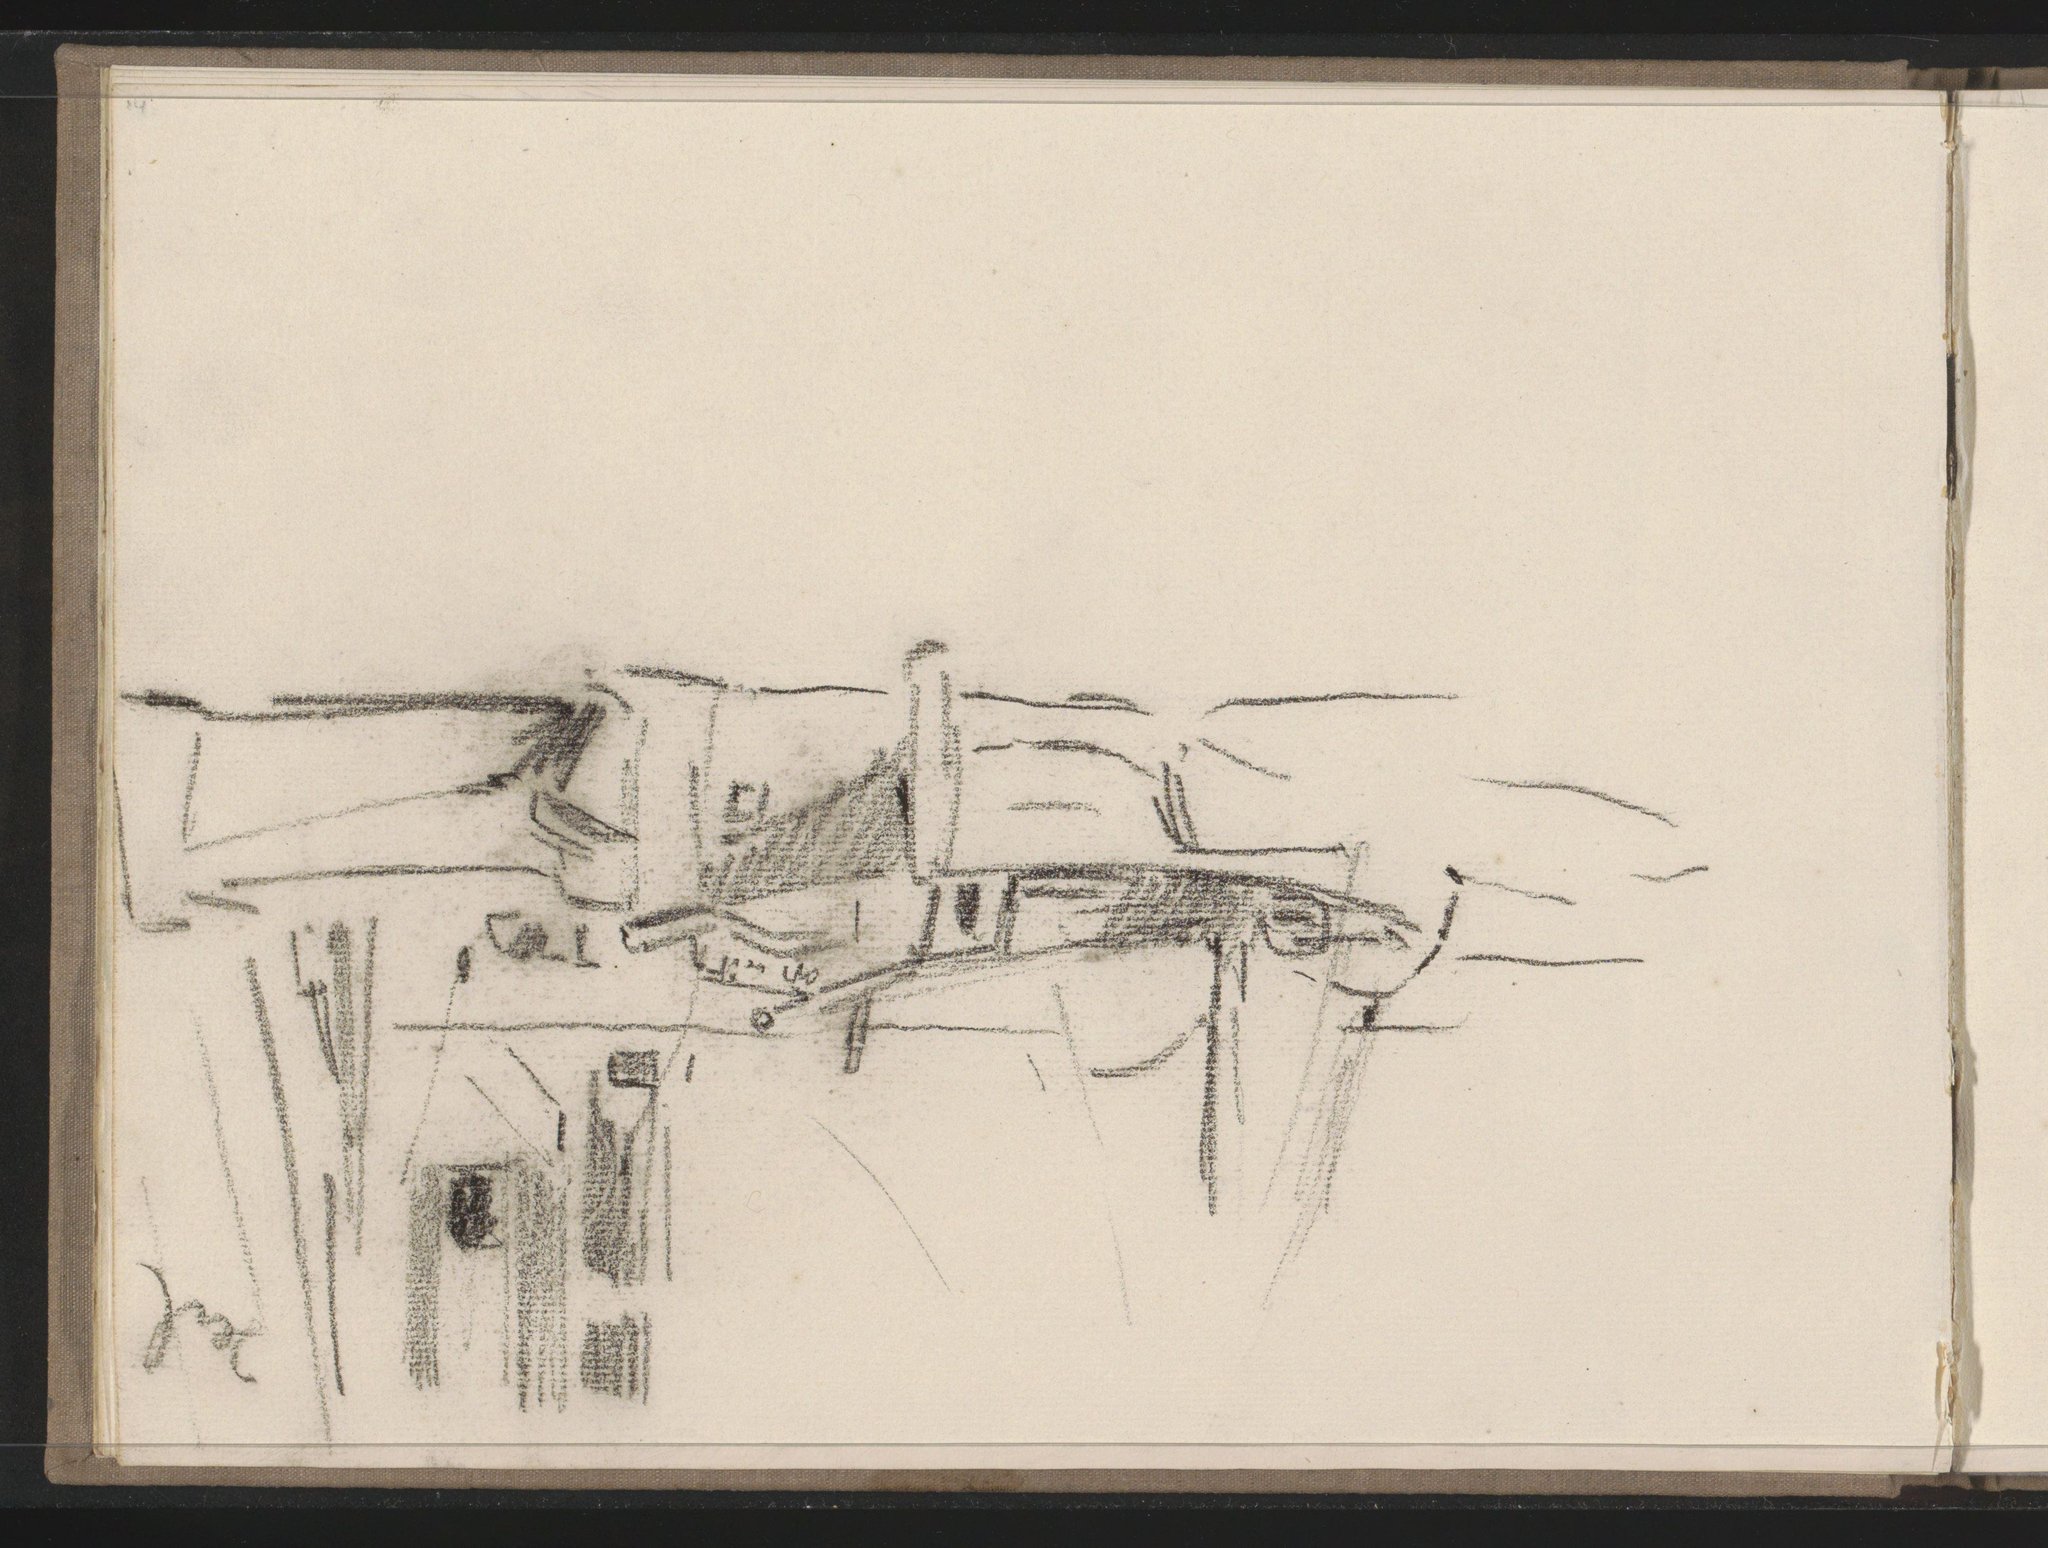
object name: sketchbook leaf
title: Kade met schepen, mogelijk het Damrak te Amsterdam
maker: willem witsen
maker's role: draughtsman, painter, print maker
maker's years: 1860-1923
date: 1901-1907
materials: chalk, paper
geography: amsterdam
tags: ships (in general), quay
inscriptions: kleurnotitie, handgeschreven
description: Pagina 14 uit een schetsboek met 72 bladen.